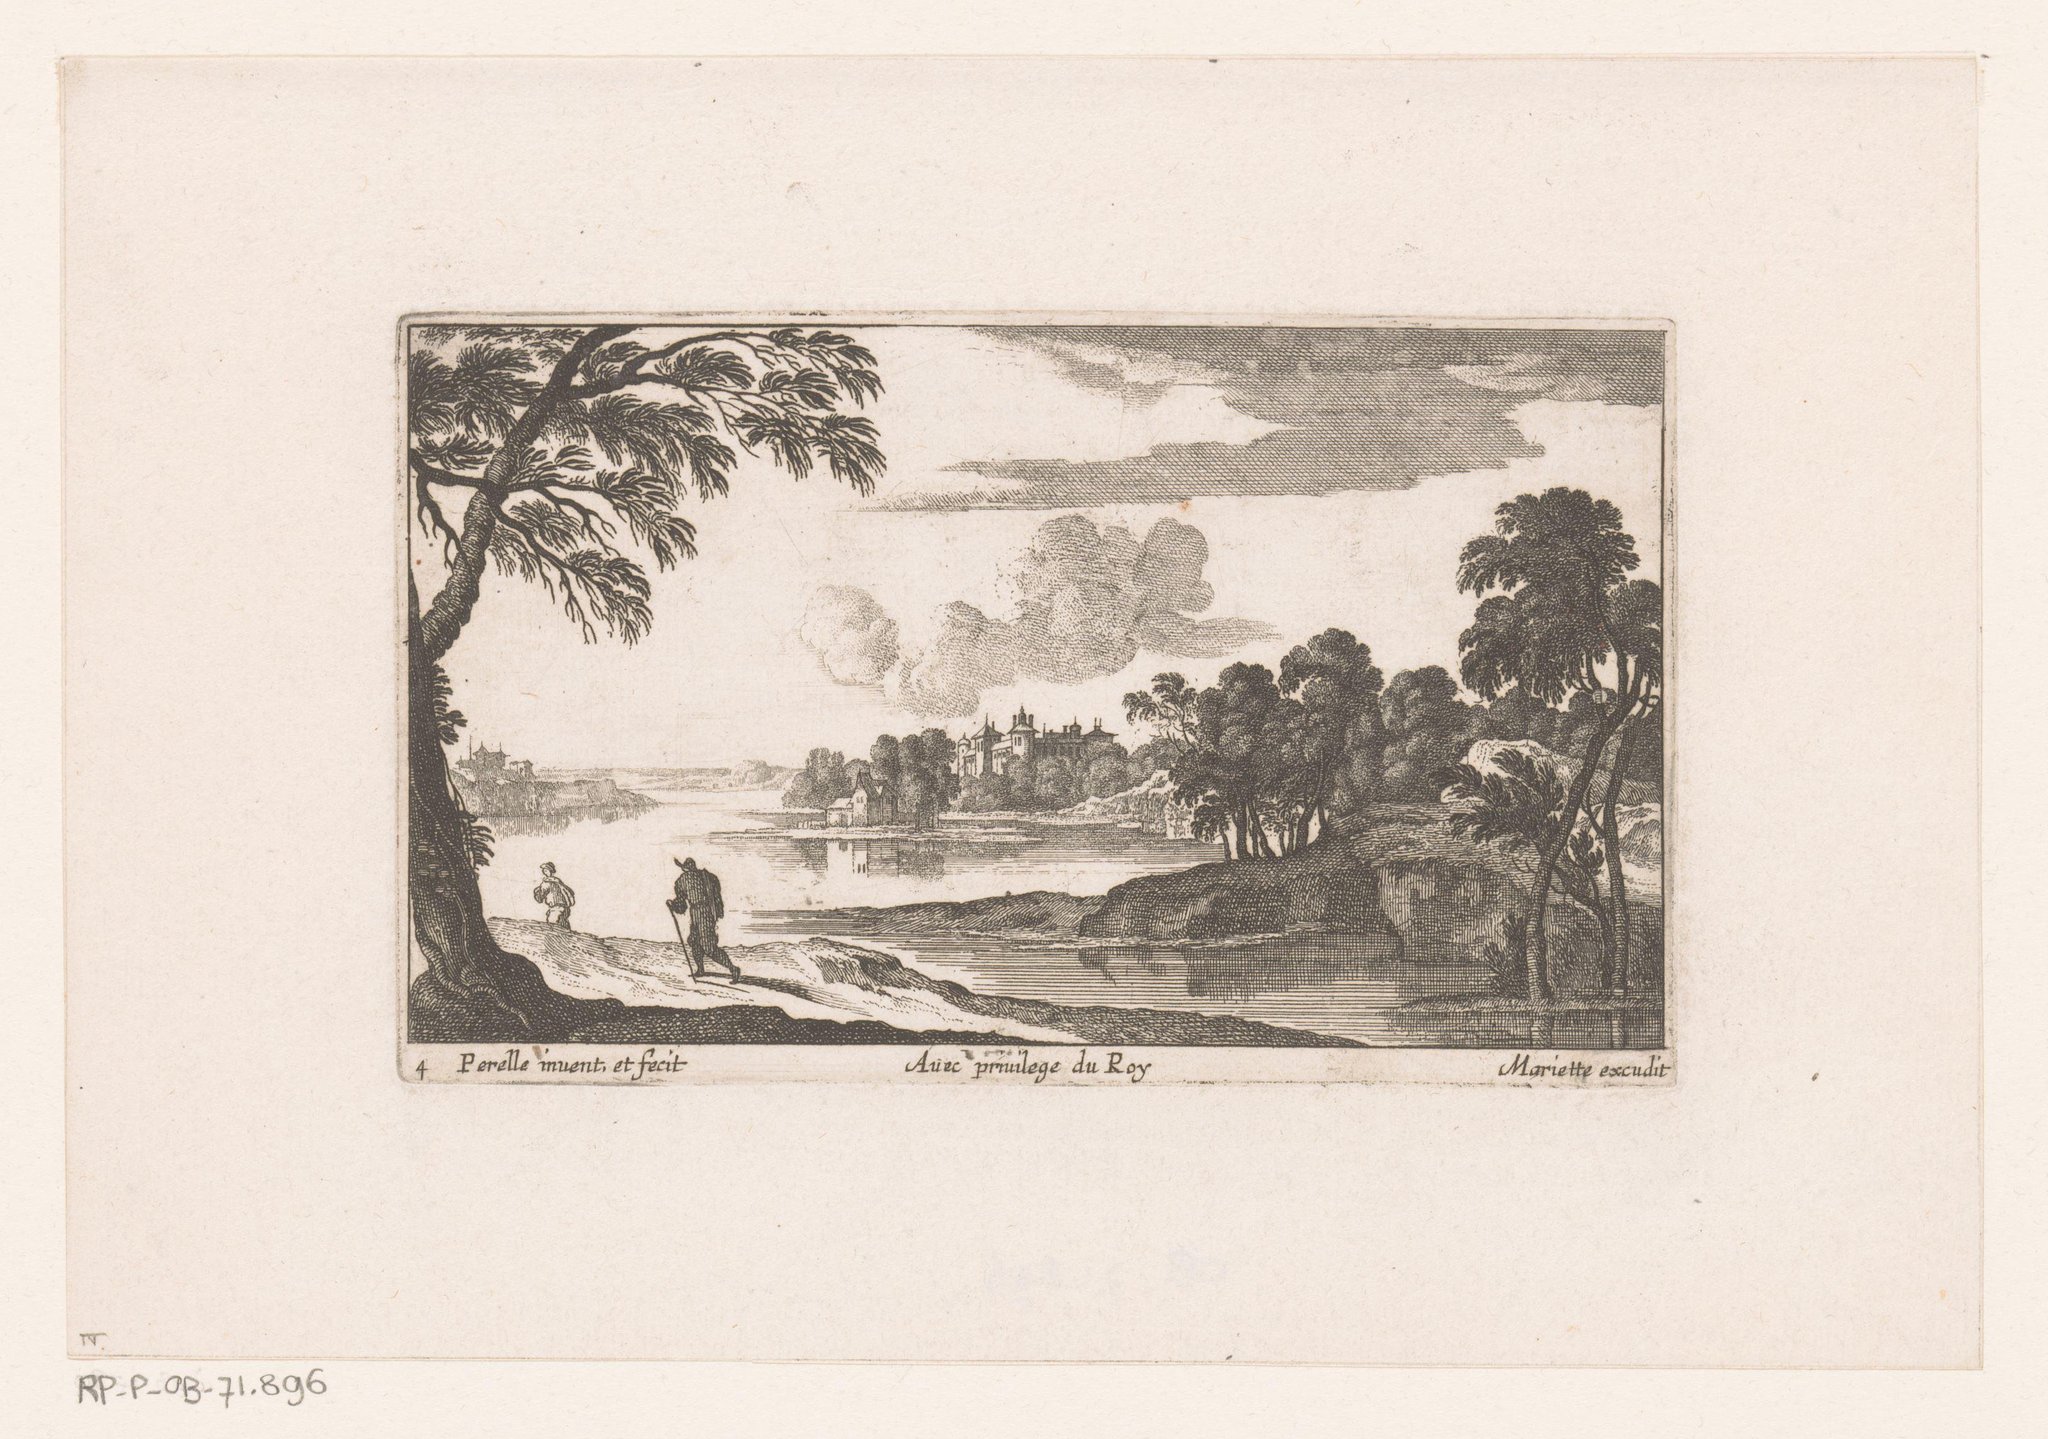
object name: print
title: Landschap met rivier en kasteel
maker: mariette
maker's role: publisher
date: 1613-1695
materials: paper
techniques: etching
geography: france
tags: landscapes with waters, waterscapes, seascapes (in the temperate zone)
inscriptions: collector's mark: Lugt 240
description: Prenten met het signatuur 'Perelle' kunnen zowel door vader Gabriel als door zonen Nicolas en Adam gemaakt zijn.